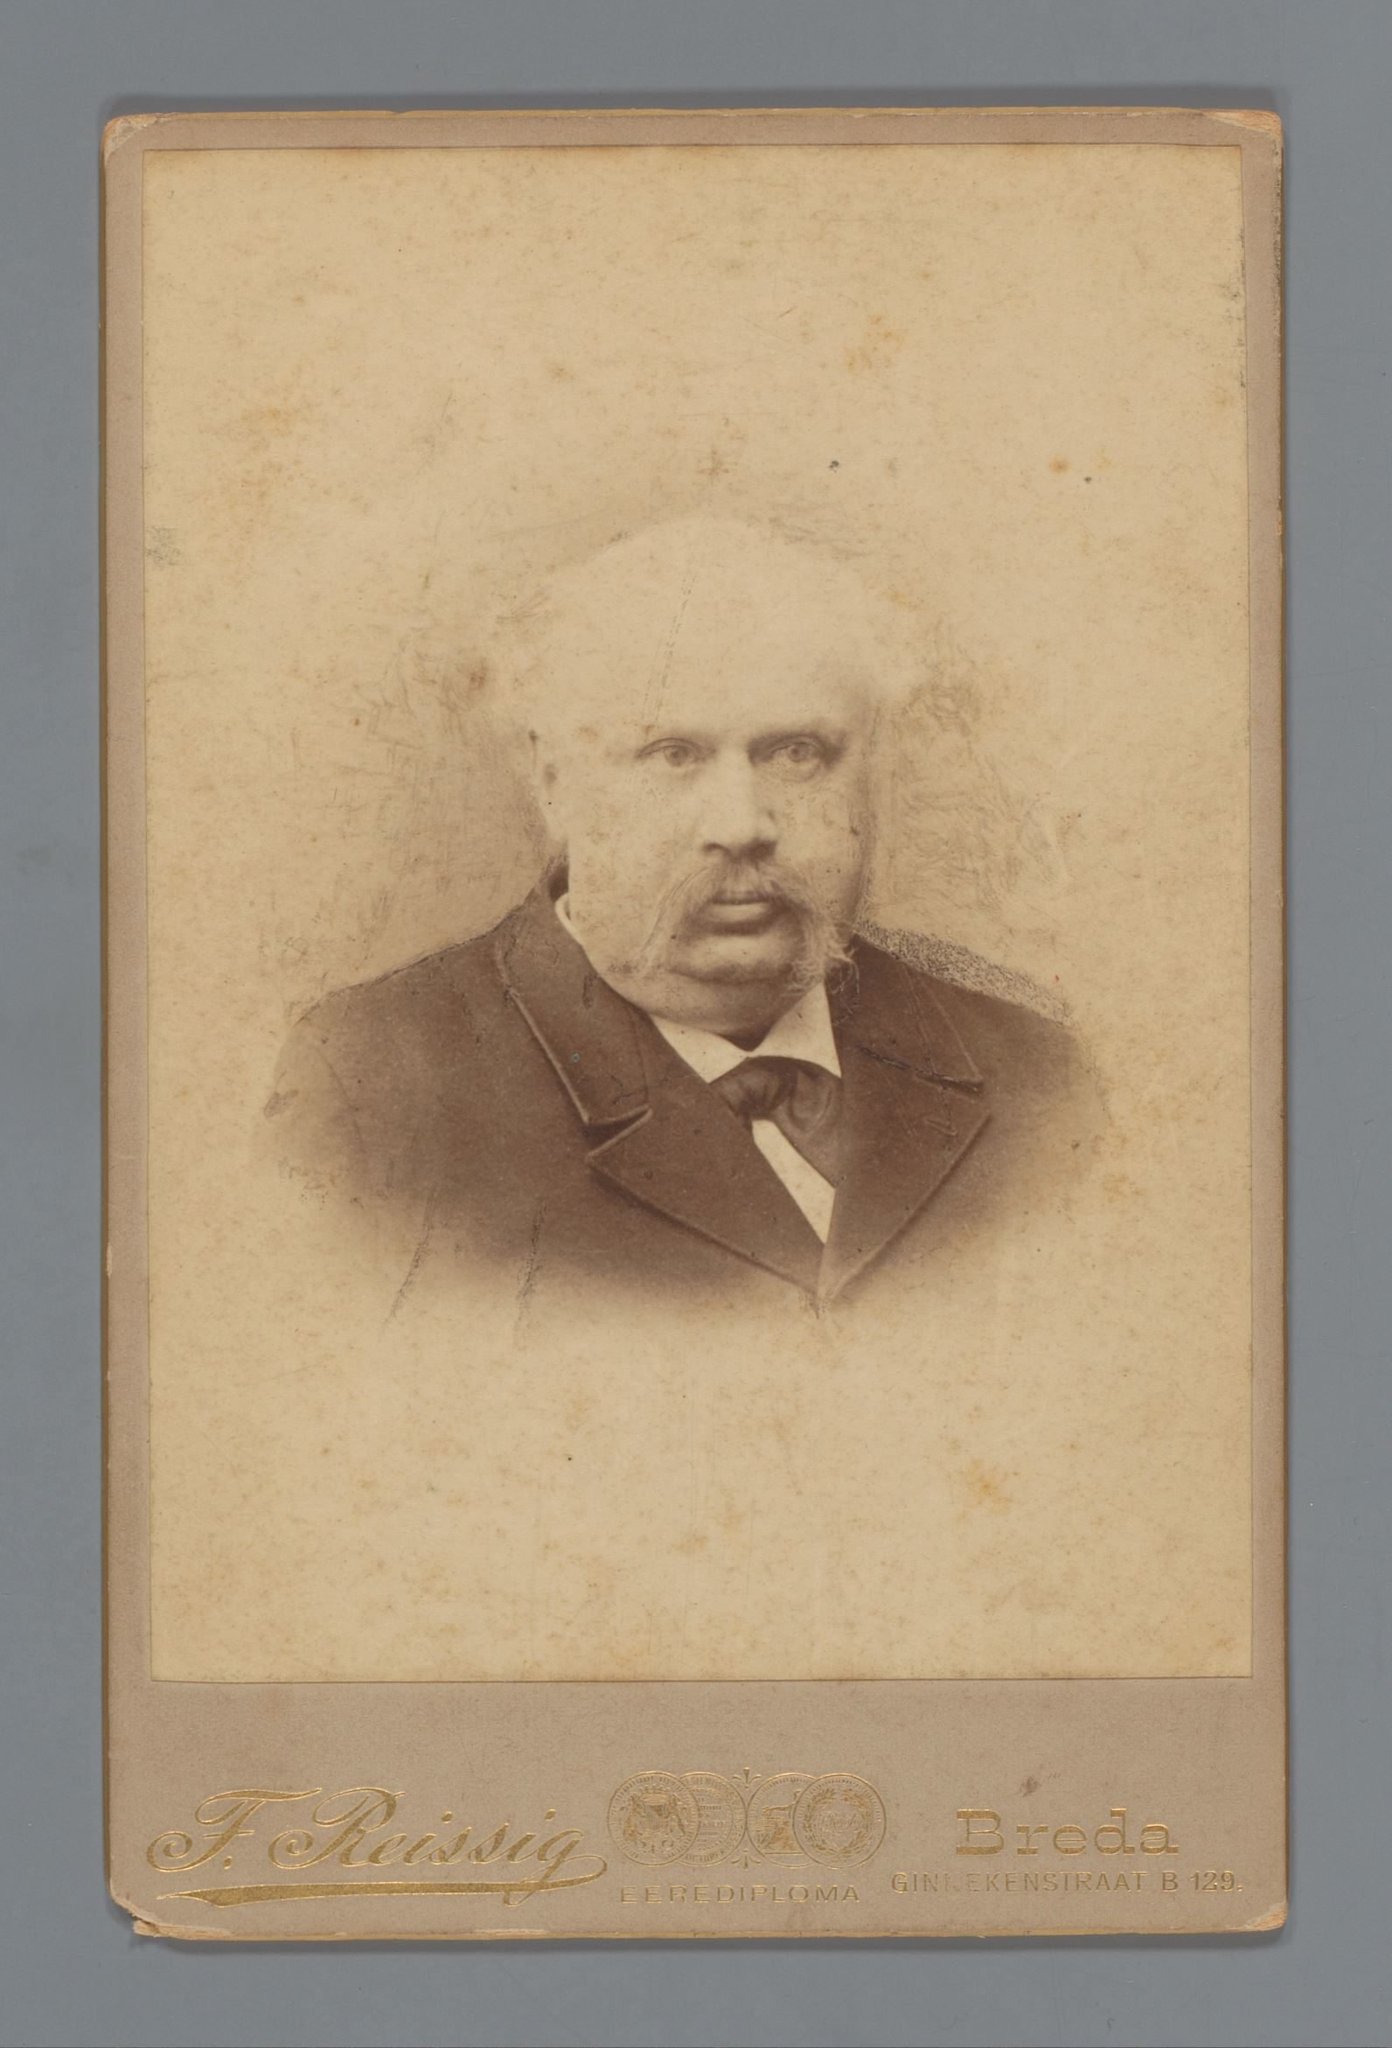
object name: cabinet photograph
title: Portret van een onbekende man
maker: franz reissig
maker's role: fotograaf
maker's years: 1852-1936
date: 1880-1900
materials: cardboard, photographic support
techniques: albumen print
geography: breda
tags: adult man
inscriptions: name: ‘F. Reissig Breda Ginnekenstraat B 129. Utrecht hoek Stationsplein en Westerstraat. De plaat blijft ter nabestelling bewaard.’